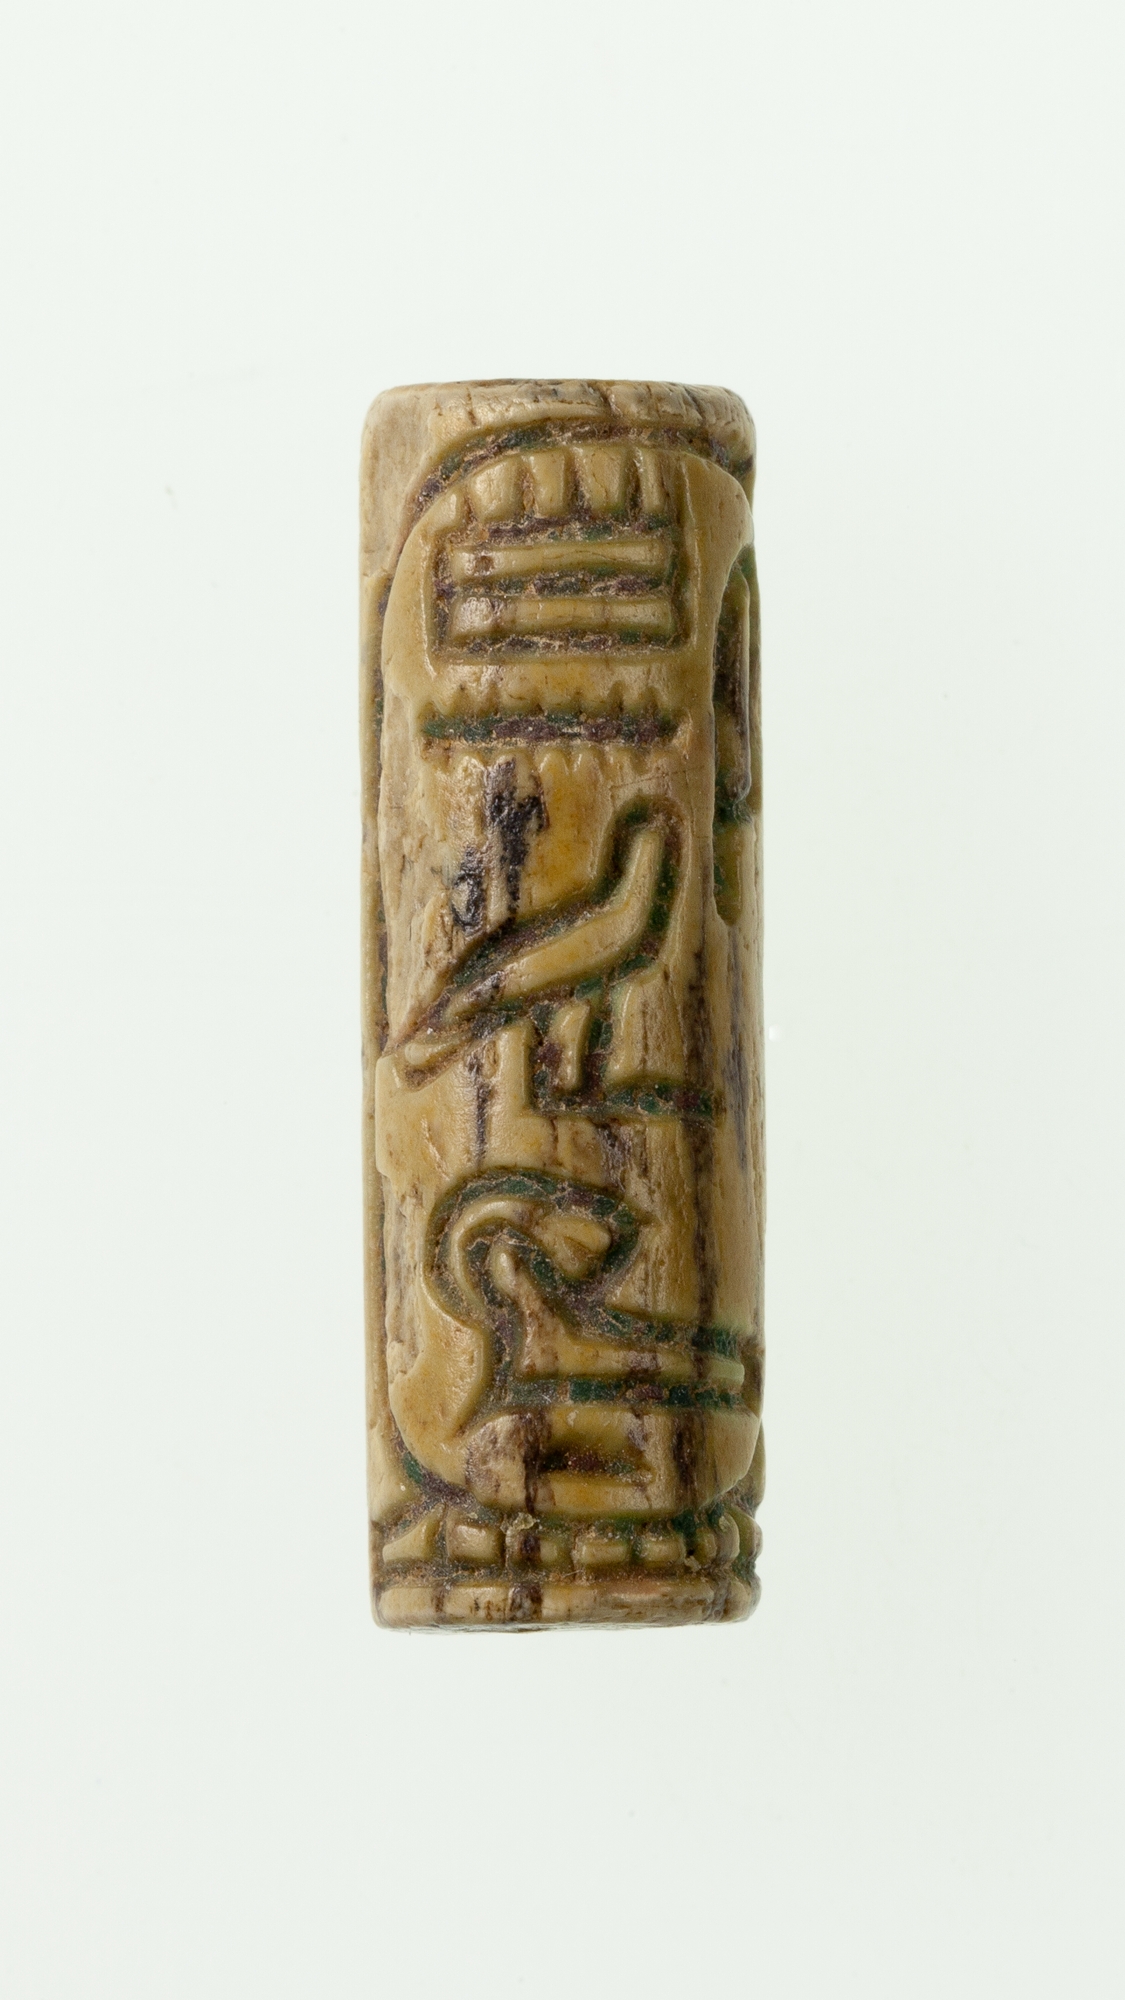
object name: cylinder seal, amenemhat iii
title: Cylinder seal of Amenemhat III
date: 1802-1550 BCE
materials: glaze, stone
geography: egypt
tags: hieroglyphs